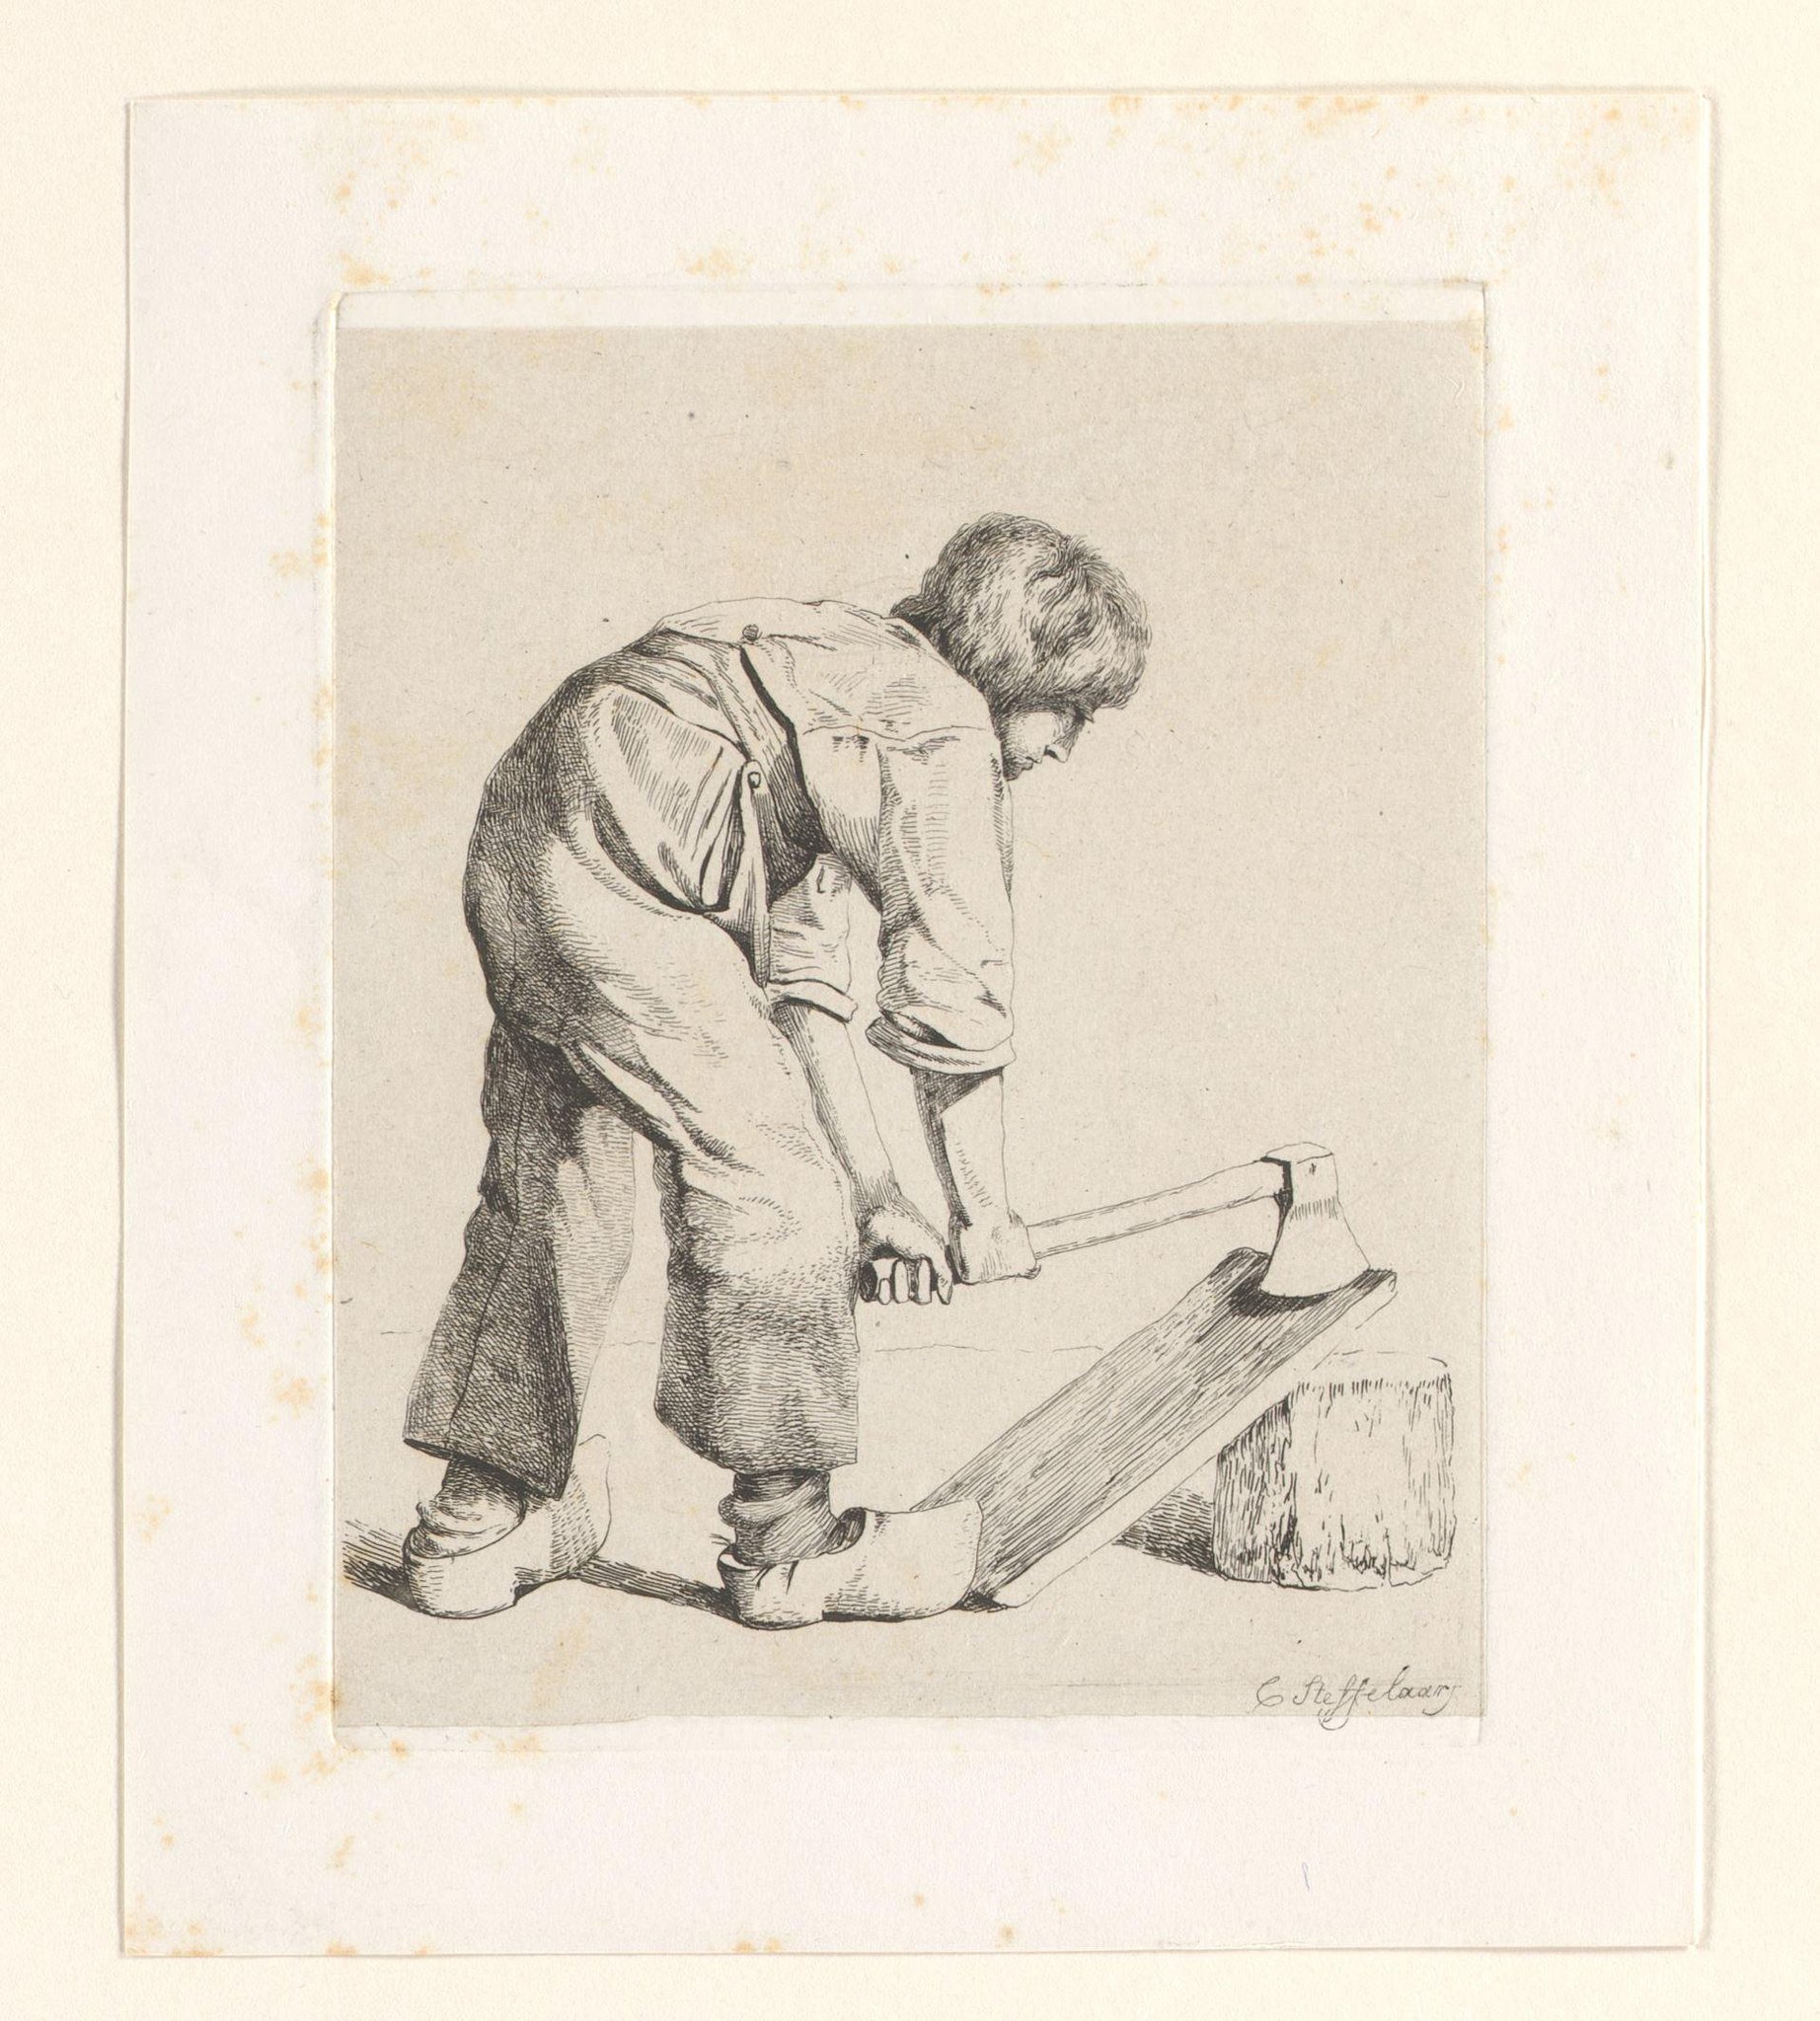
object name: print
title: Vierde suite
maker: cornelis steffelaar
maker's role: draughtsman, painter, print maker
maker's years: 1797-1861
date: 1807-1861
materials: paper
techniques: etching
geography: amsterdam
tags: chopping (industrial process), wooden shoes, clogs, tools, aids, implements ~ crafts and industries: axe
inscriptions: number: ‘29’, collector's mark: Lugt 1485, collector's mark: Lugt 2228